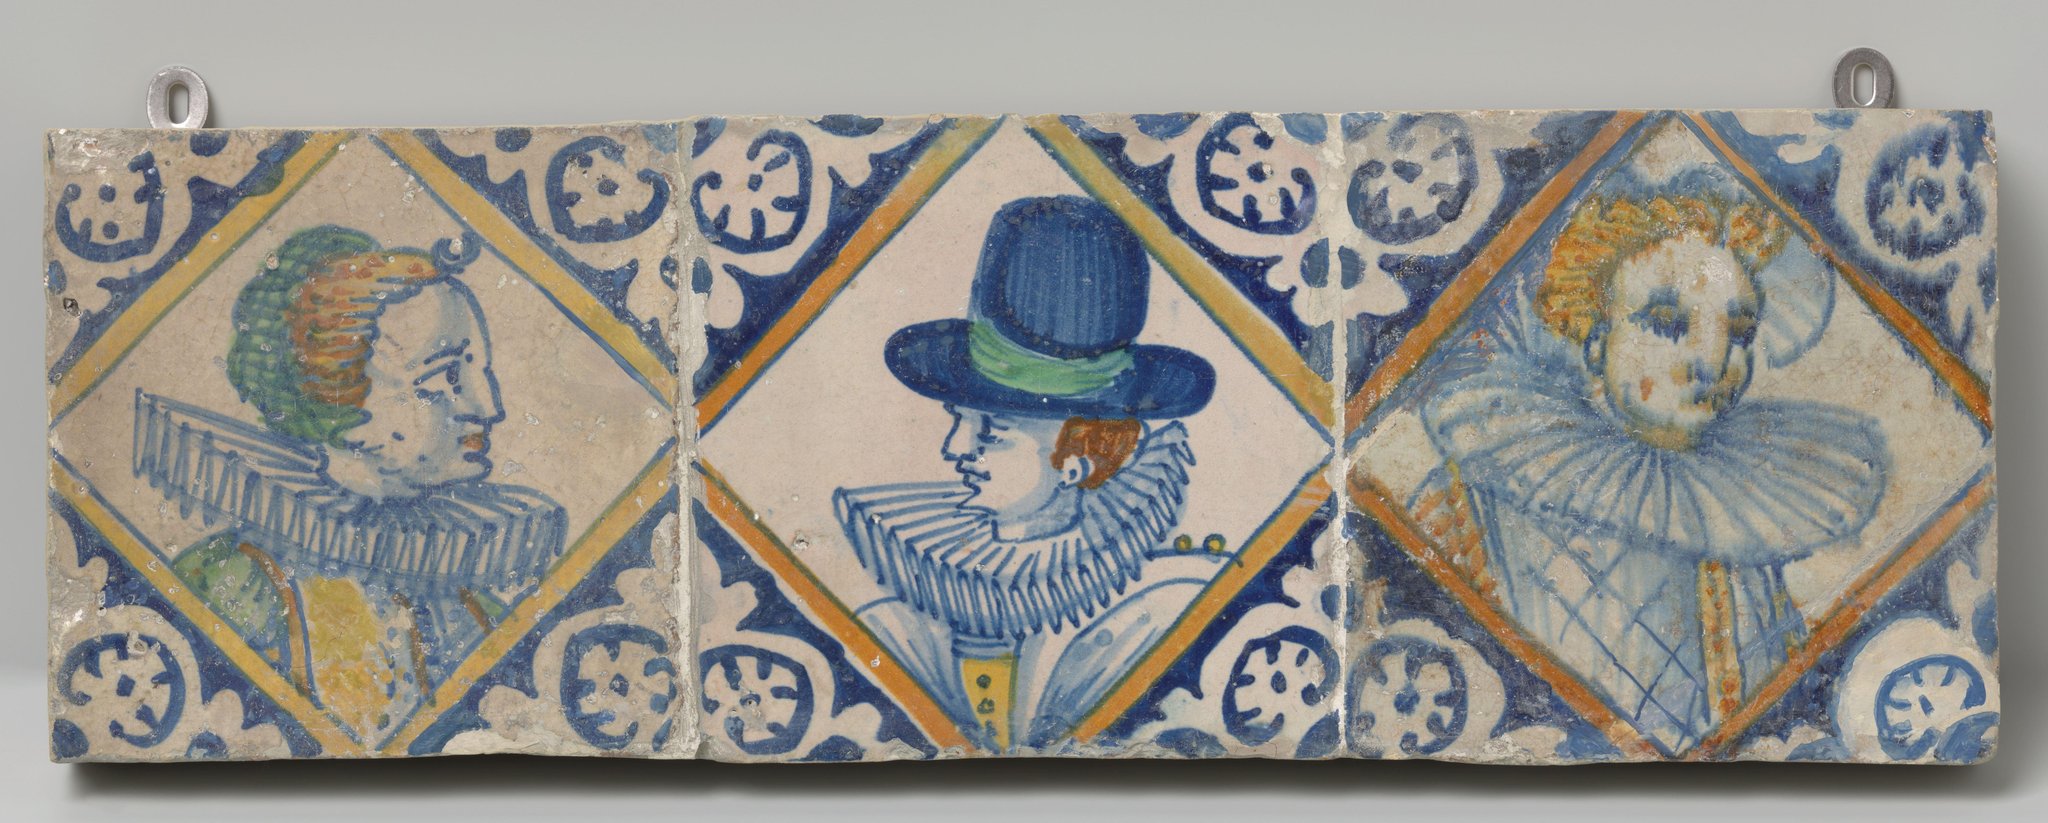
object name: tile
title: Tegel met vrouw met plooikraag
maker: Anonymous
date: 1580-1625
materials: earthenware, glaze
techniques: maiolica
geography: netherlands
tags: neck-gear ~ clothing (with name), anonymous historical person portrayed - bb - woman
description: Tegel met een veelkleurig (blauw, oranje, geel en groen) portret van een vrouw met plooikraag binnen een kwadraat met in de hoeken, ornament in vultechniek.